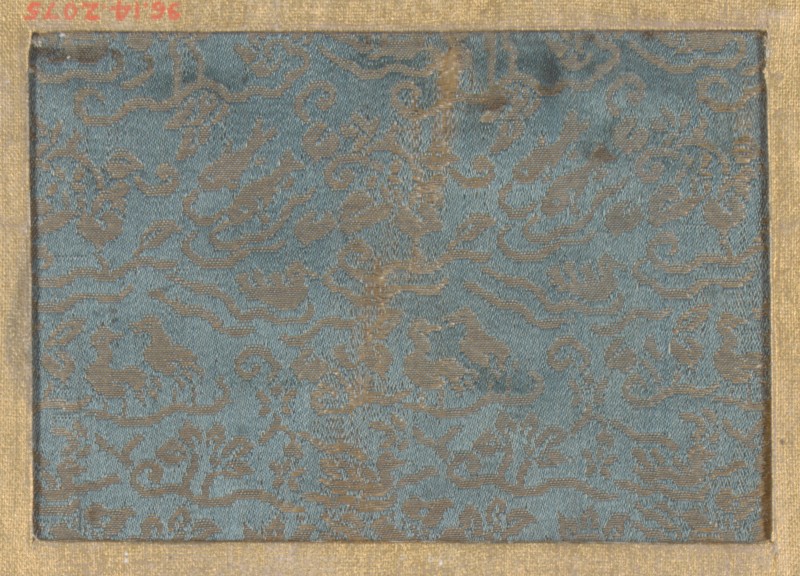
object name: piece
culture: japanese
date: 1701-1900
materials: silk